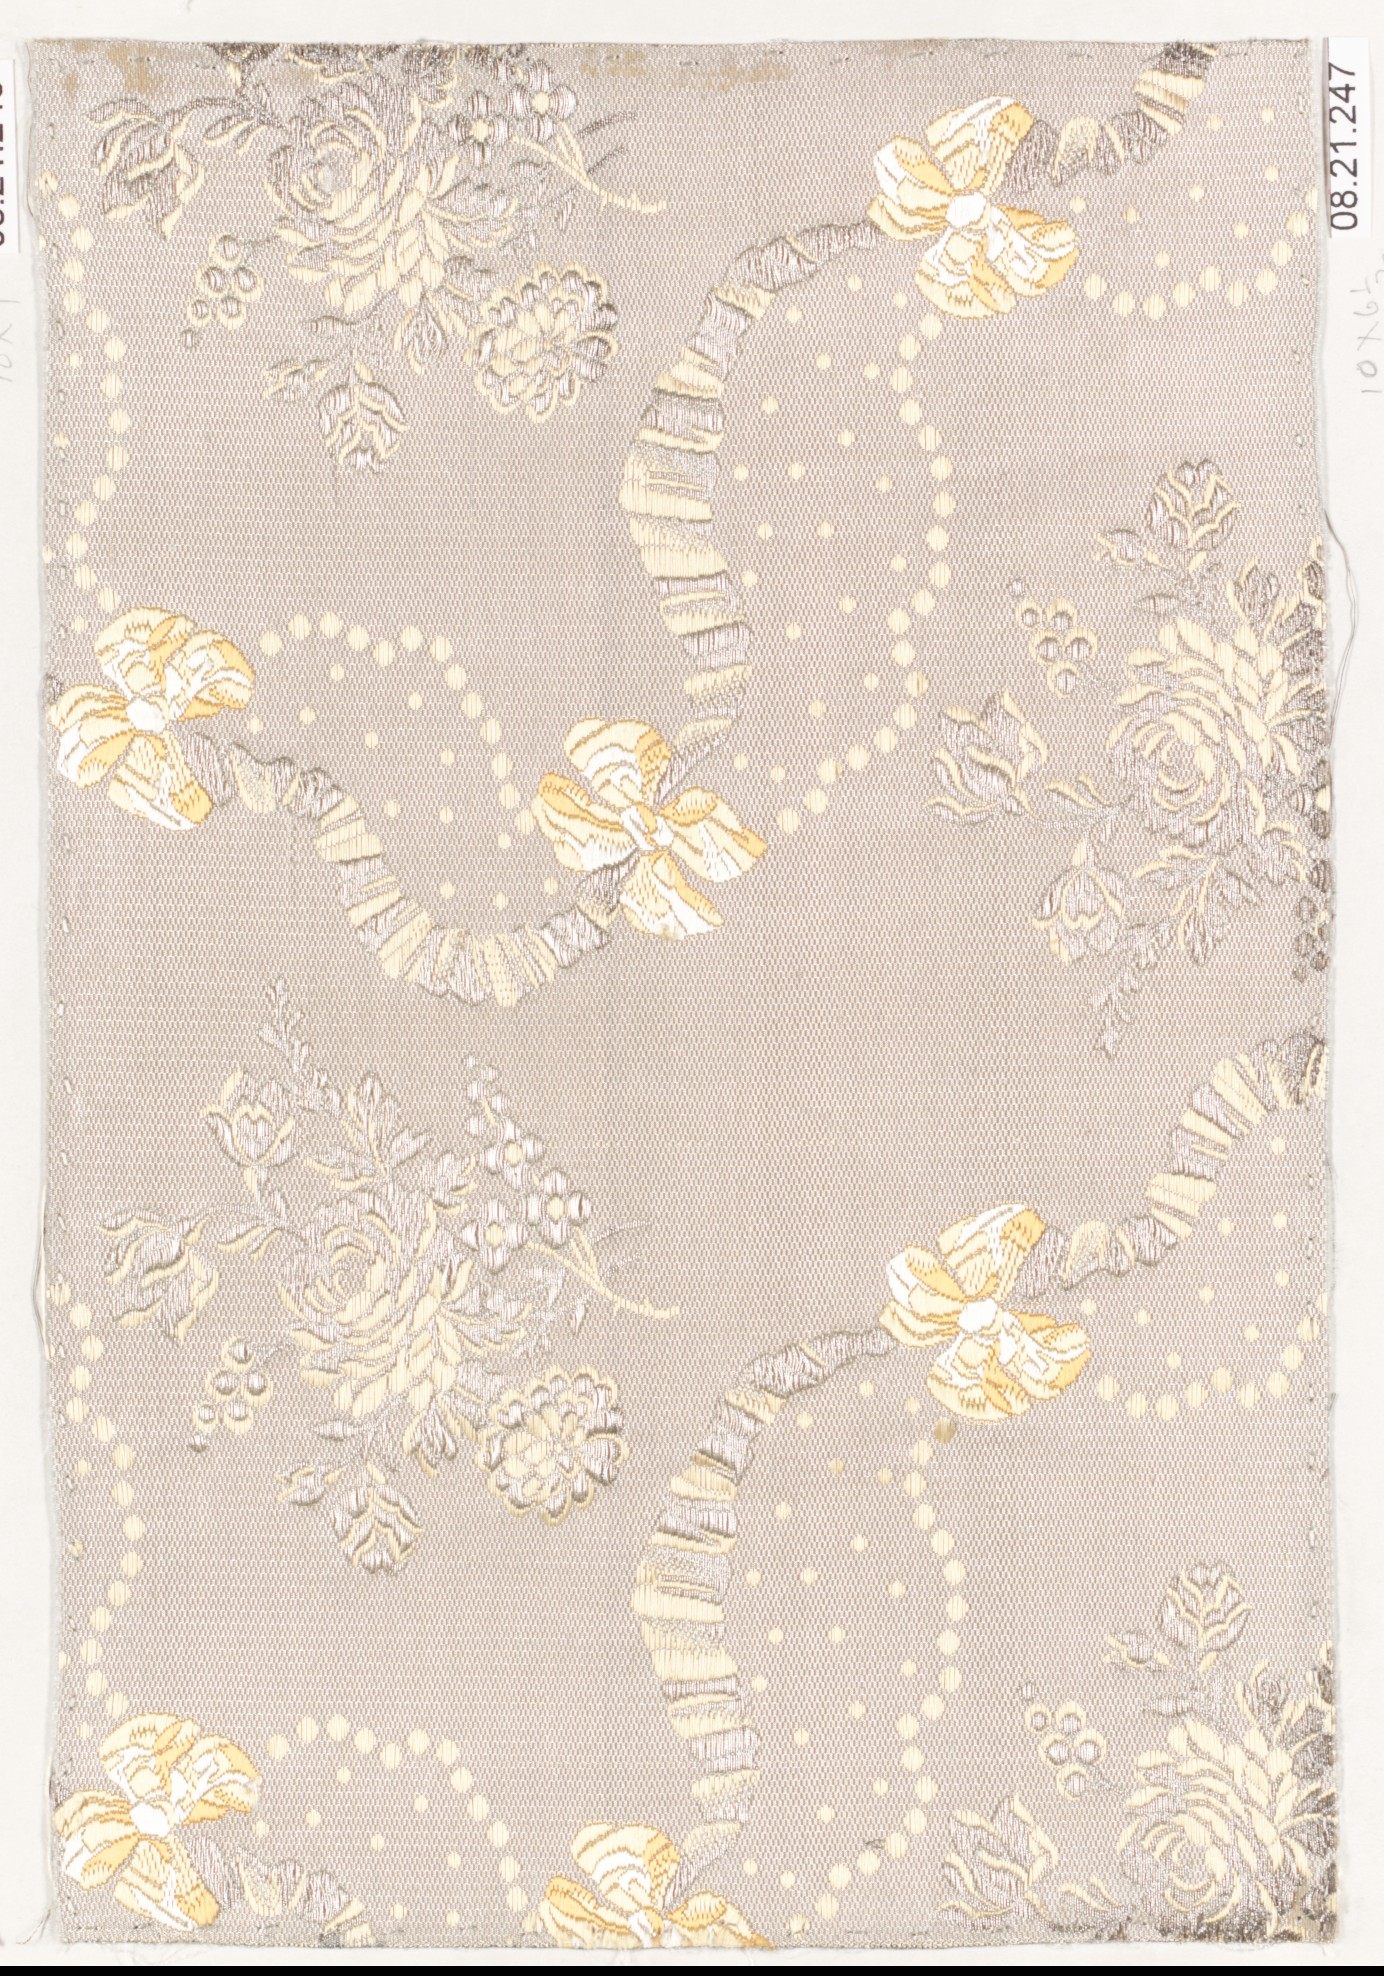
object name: textile sample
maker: Anonymous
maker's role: designer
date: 1900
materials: silk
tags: flowers